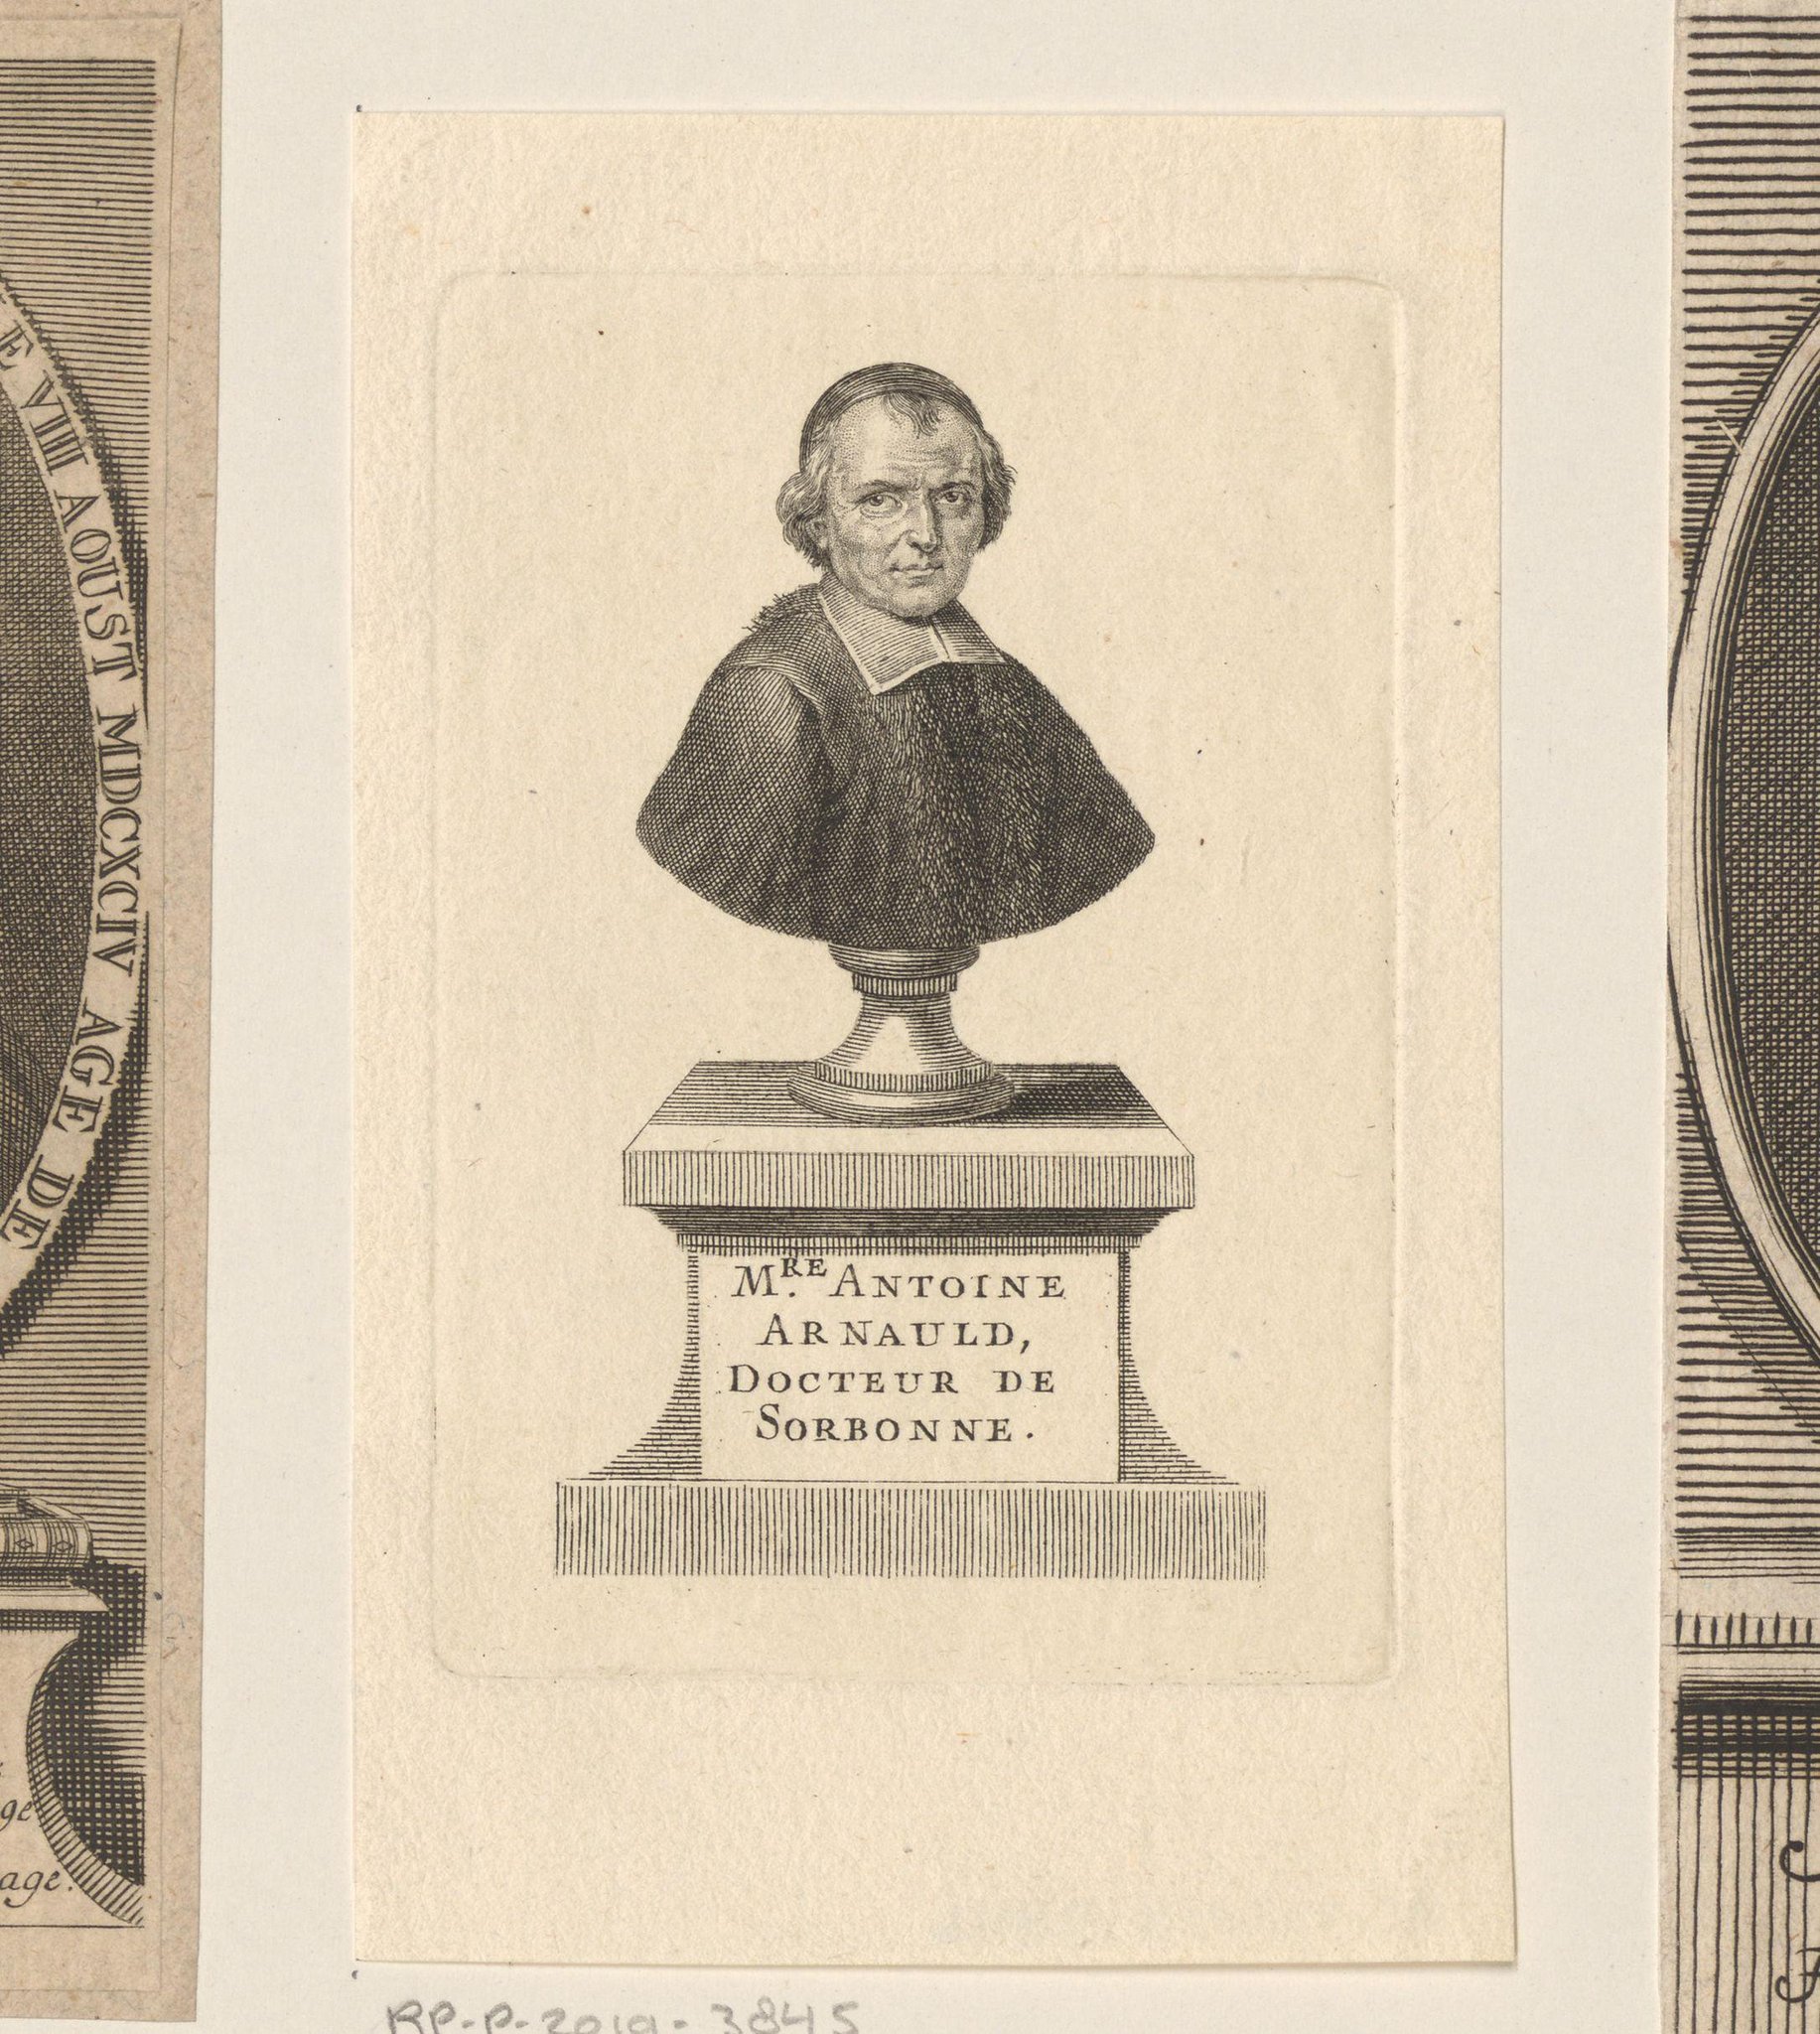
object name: print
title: Portret van Antoine Arnauld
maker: Anonymous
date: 1700-1749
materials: paper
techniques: etching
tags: paris, brussels, historical persons, pedestal of a piece of sculpture (perhaps in the form of a herm)